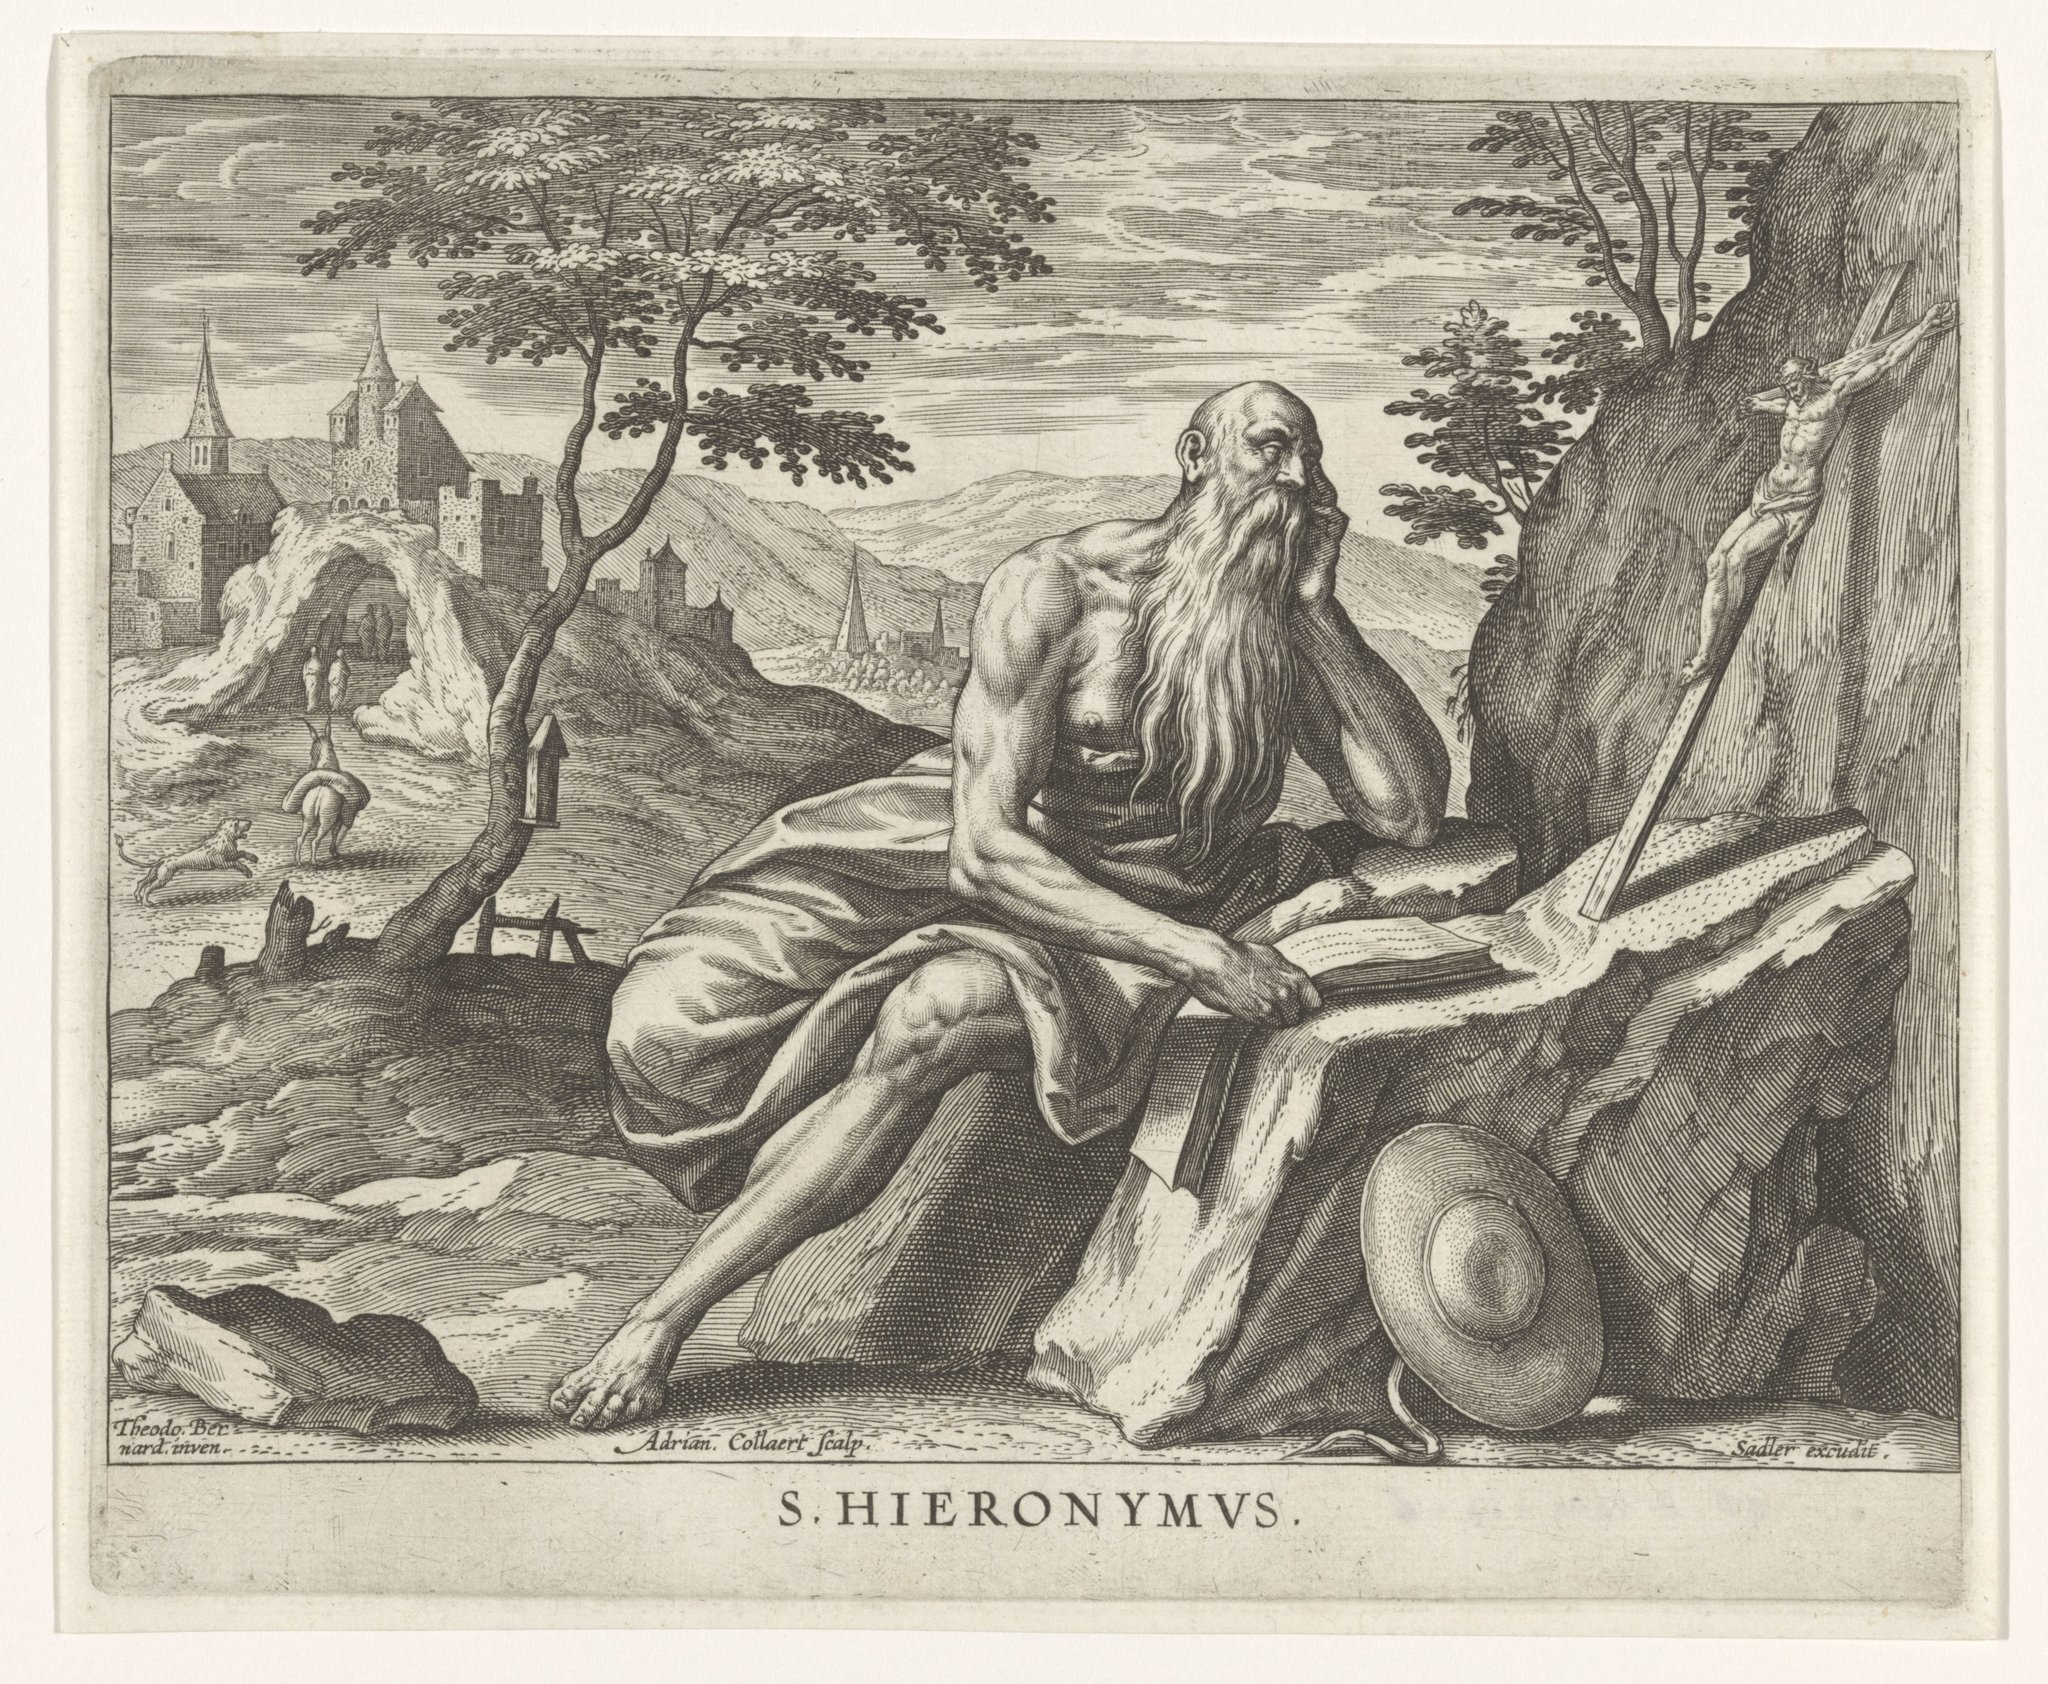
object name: print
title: De vier kerkvaders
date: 1570-1590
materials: paper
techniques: engraving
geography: southern netherlands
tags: st. jerome as doctor of the latin church in his study with book, pen and ink; lion and cardinal's hat beside him, doctors (fathers) of the church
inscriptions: collector's mark: Lugt 2760, collector's mark: Lugt 2228, collector's mark: Lugt 2524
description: H. Hiëronymus, als kluizenaar in de wildernis, met opengeslagen boek en kruisbeeld. Onderdeel van de serie van de vier kerkvaders.